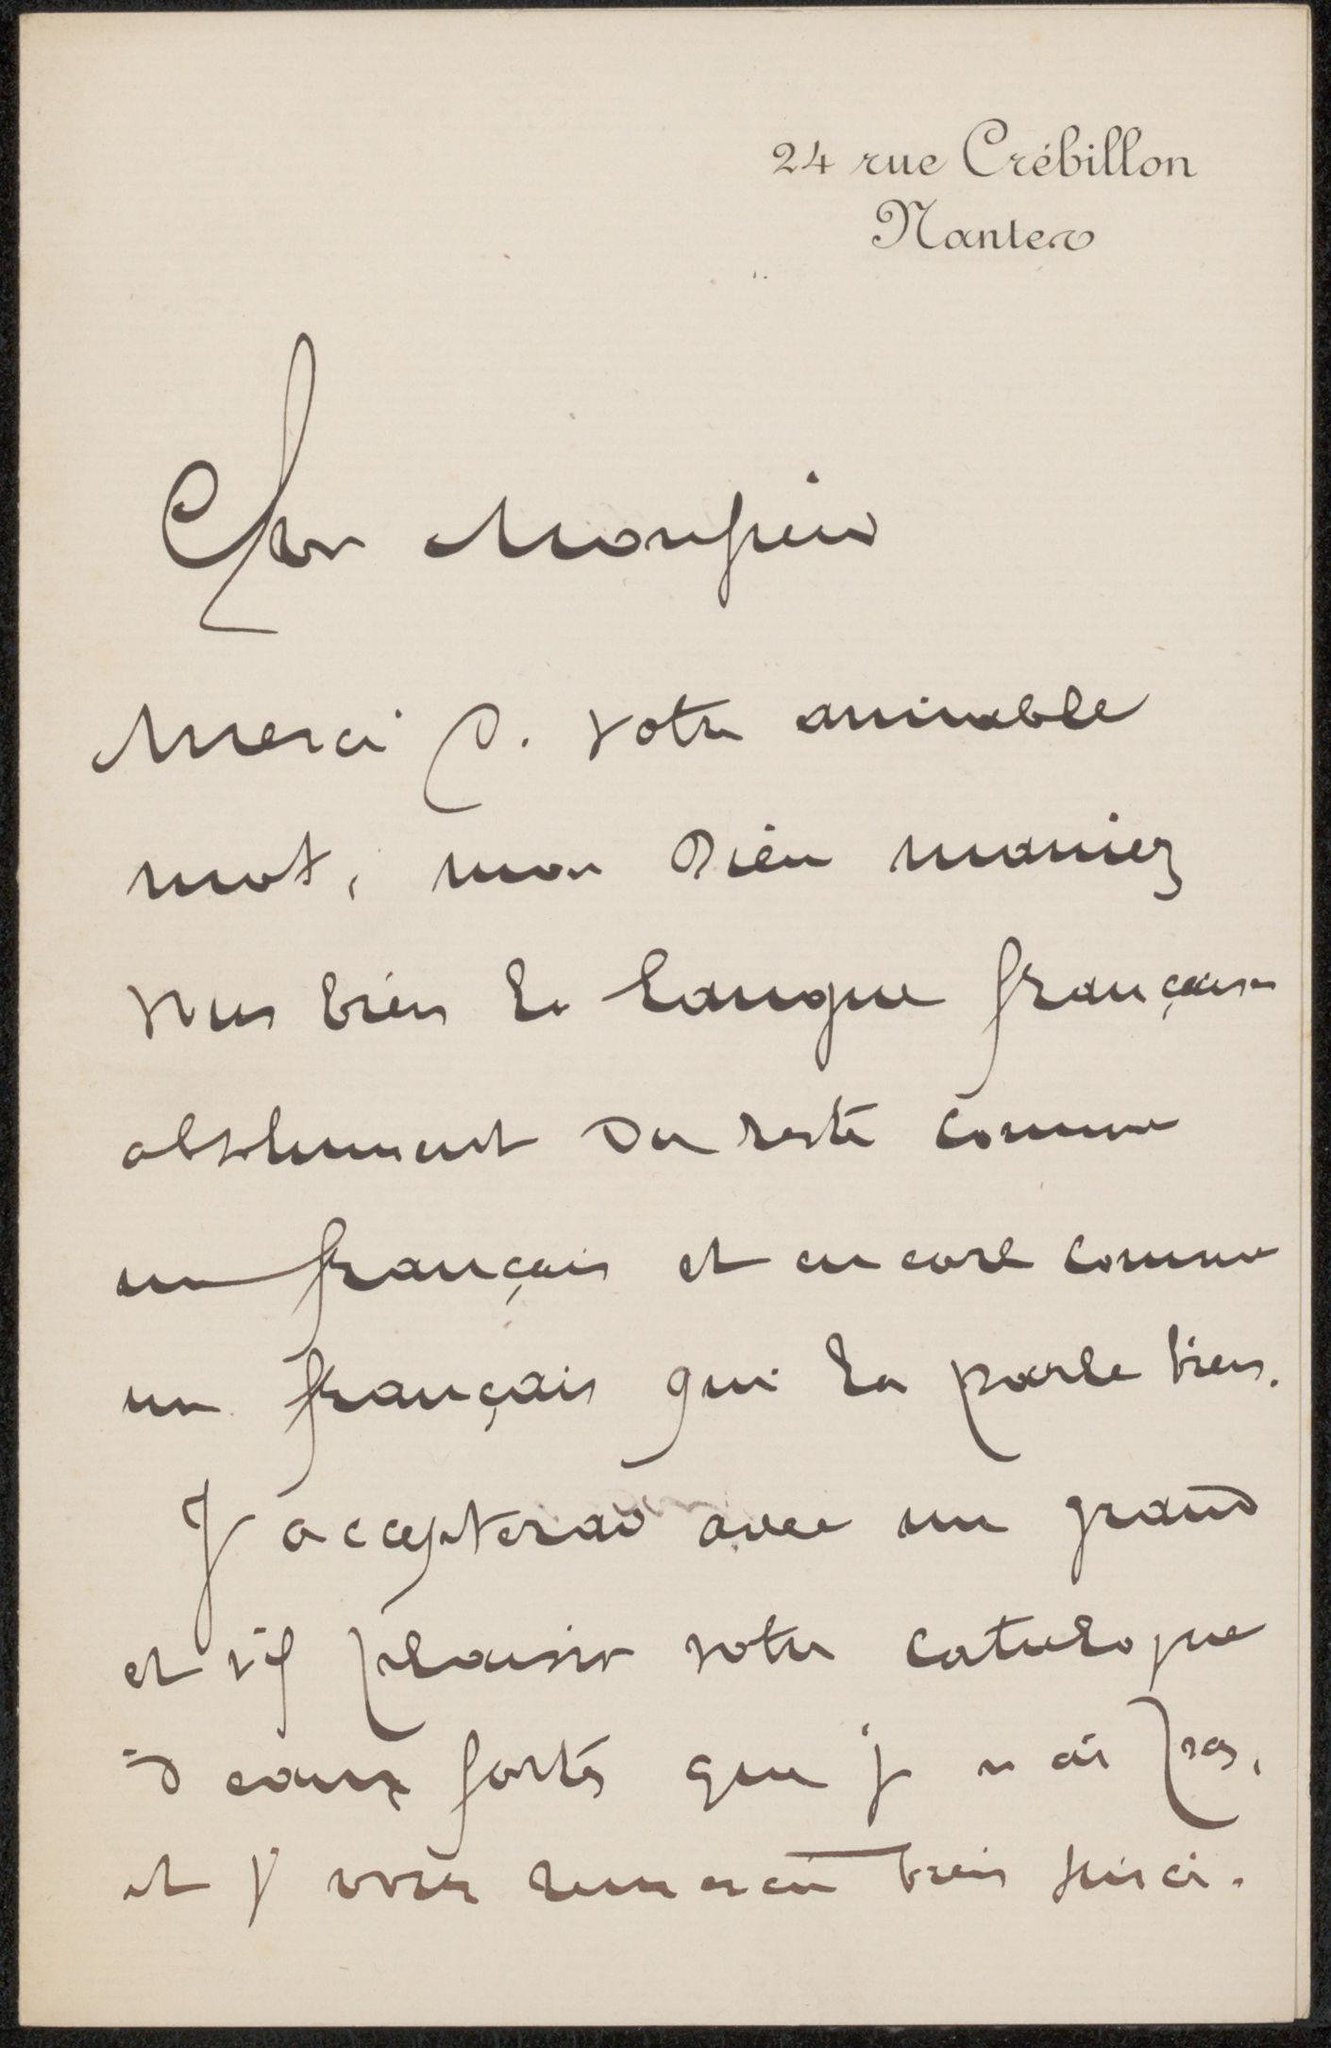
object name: letter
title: Brief aan Philip Zilcken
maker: gustave bourcard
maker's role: verzamelaar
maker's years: 1846-1925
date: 1892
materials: ink, paper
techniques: pen, printing, writing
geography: nantes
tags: painter, draughtsman, philip zilcken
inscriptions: collector's mark: ‘RPK’